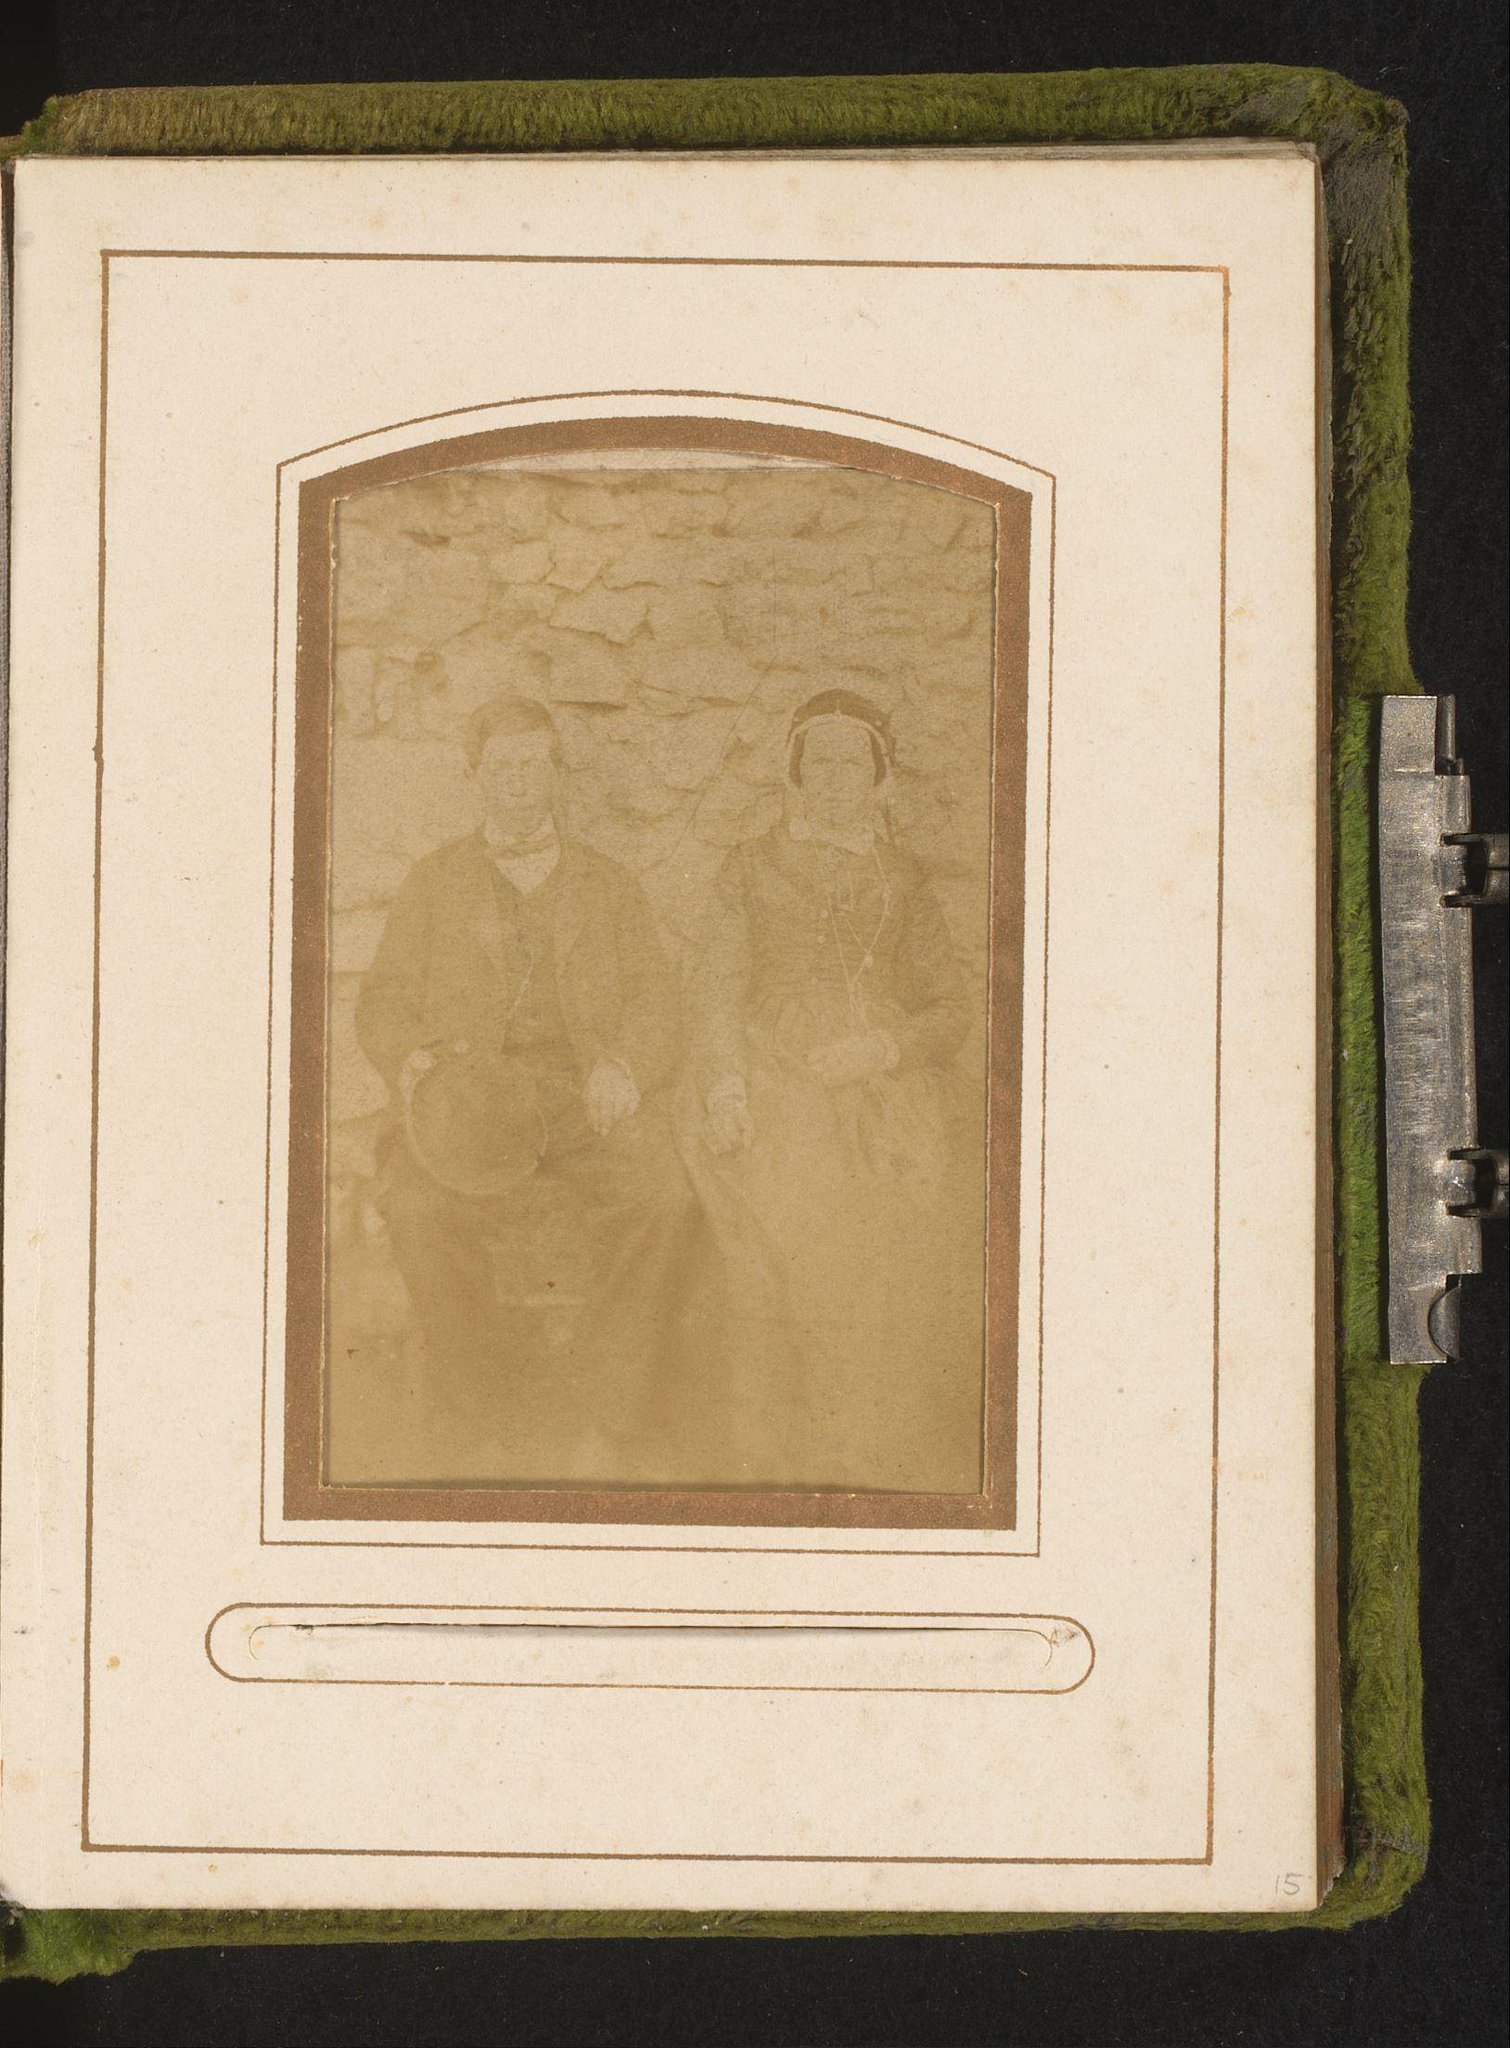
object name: carte de visite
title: Portret van een man en vrouw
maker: Anonymous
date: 1860-1900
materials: cardboard, photographic support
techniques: albumen print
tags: adult woman, adult man, historical persons